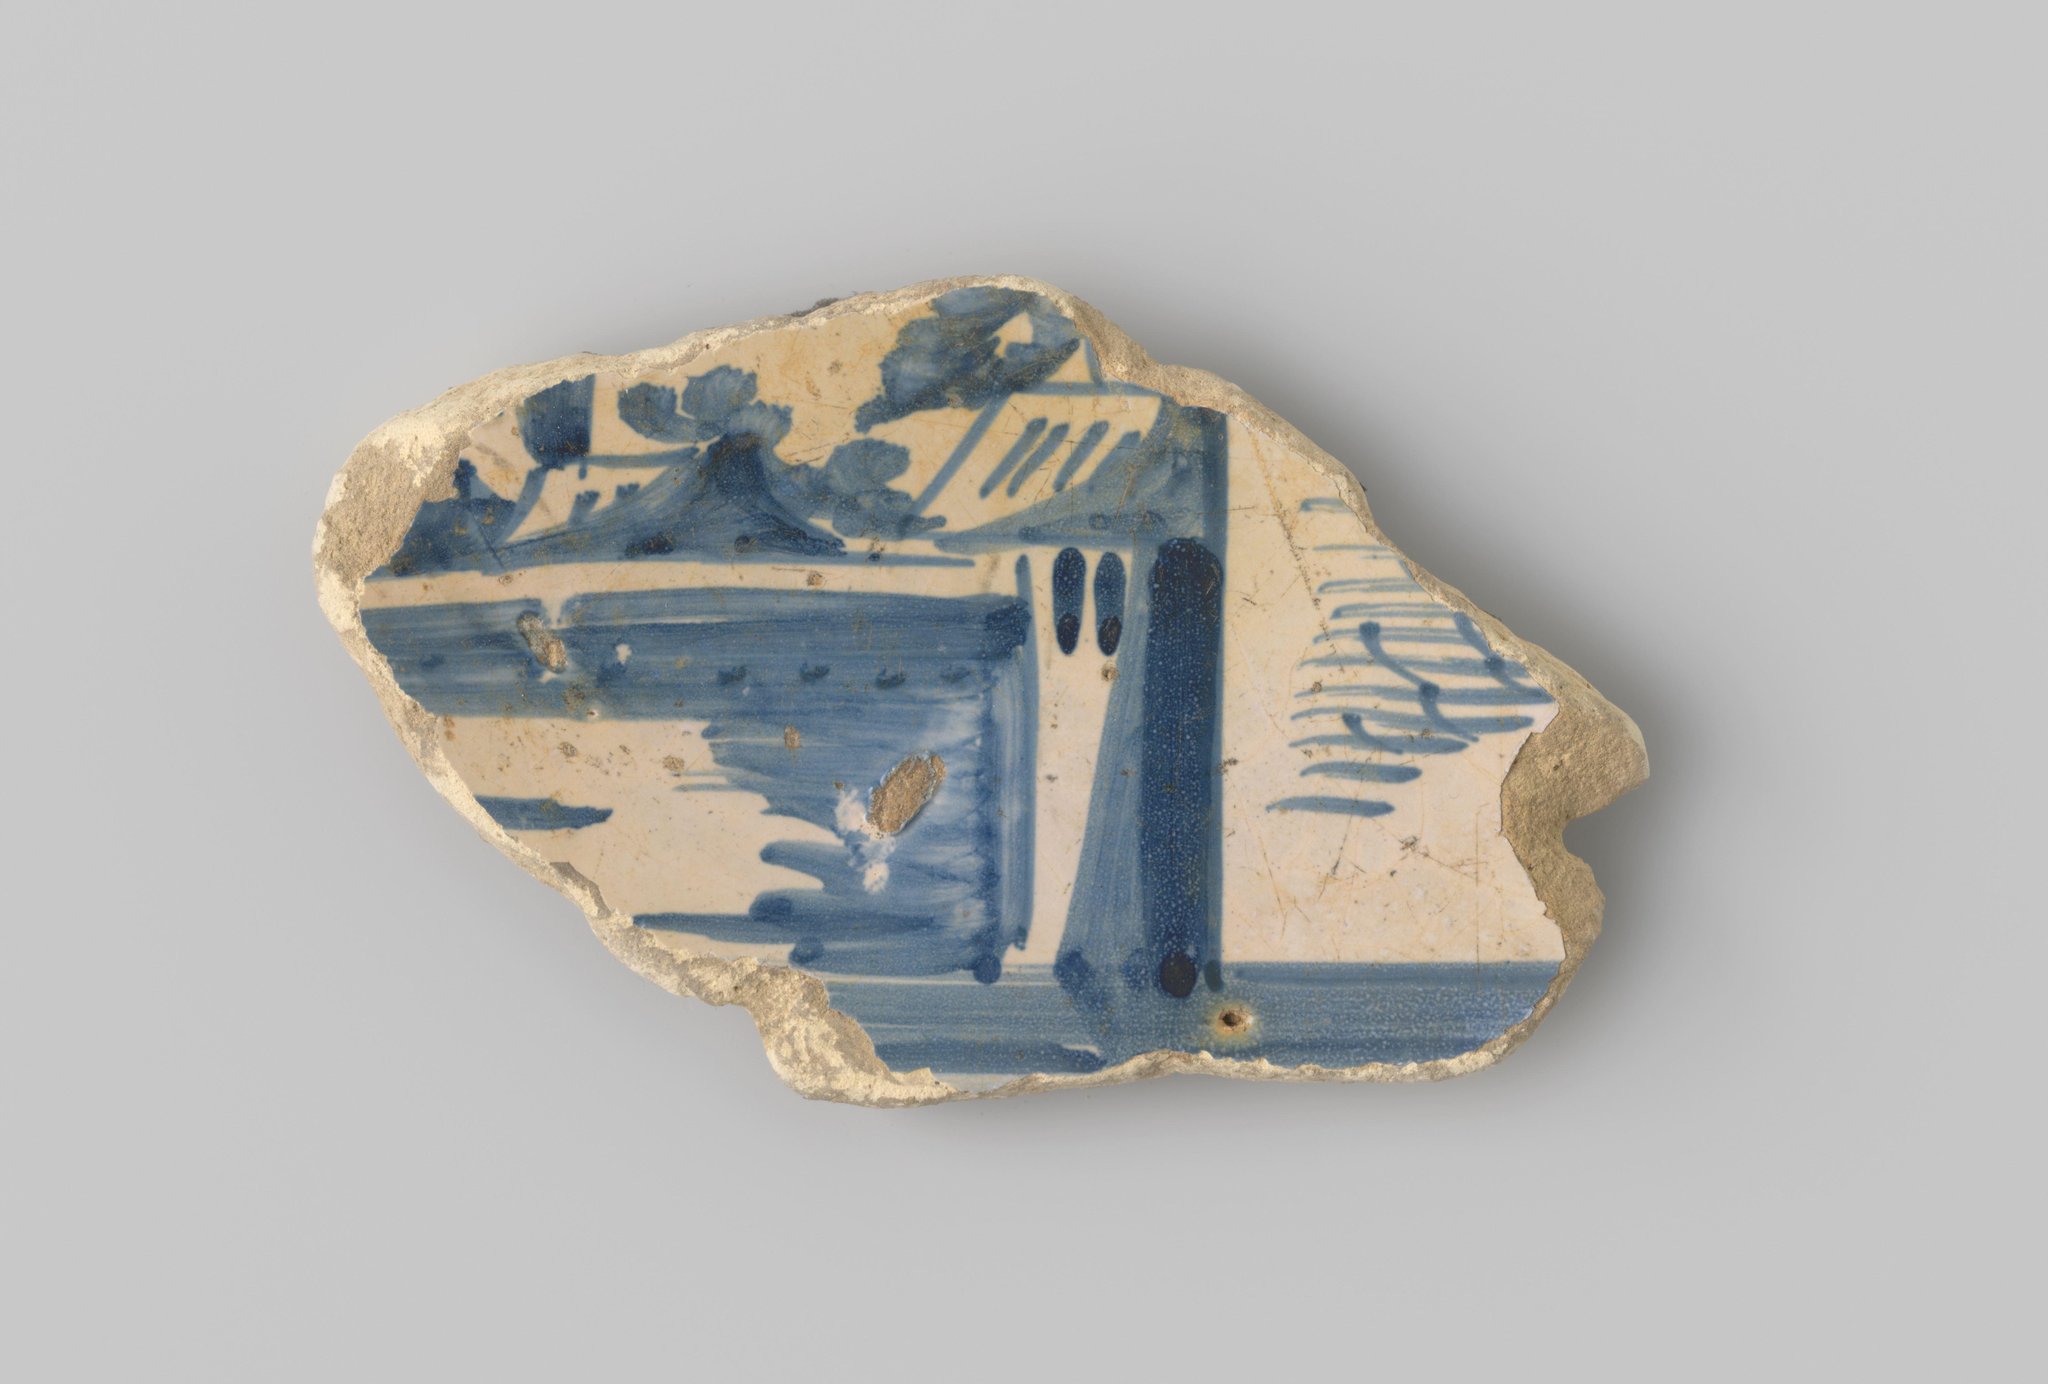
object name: fragment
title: Fragment van een schotel met gelige scherf, voorzien van een schildering van een gebouw in blauw op een witte ondergrond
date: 1500-1899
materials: earthenware, glaze